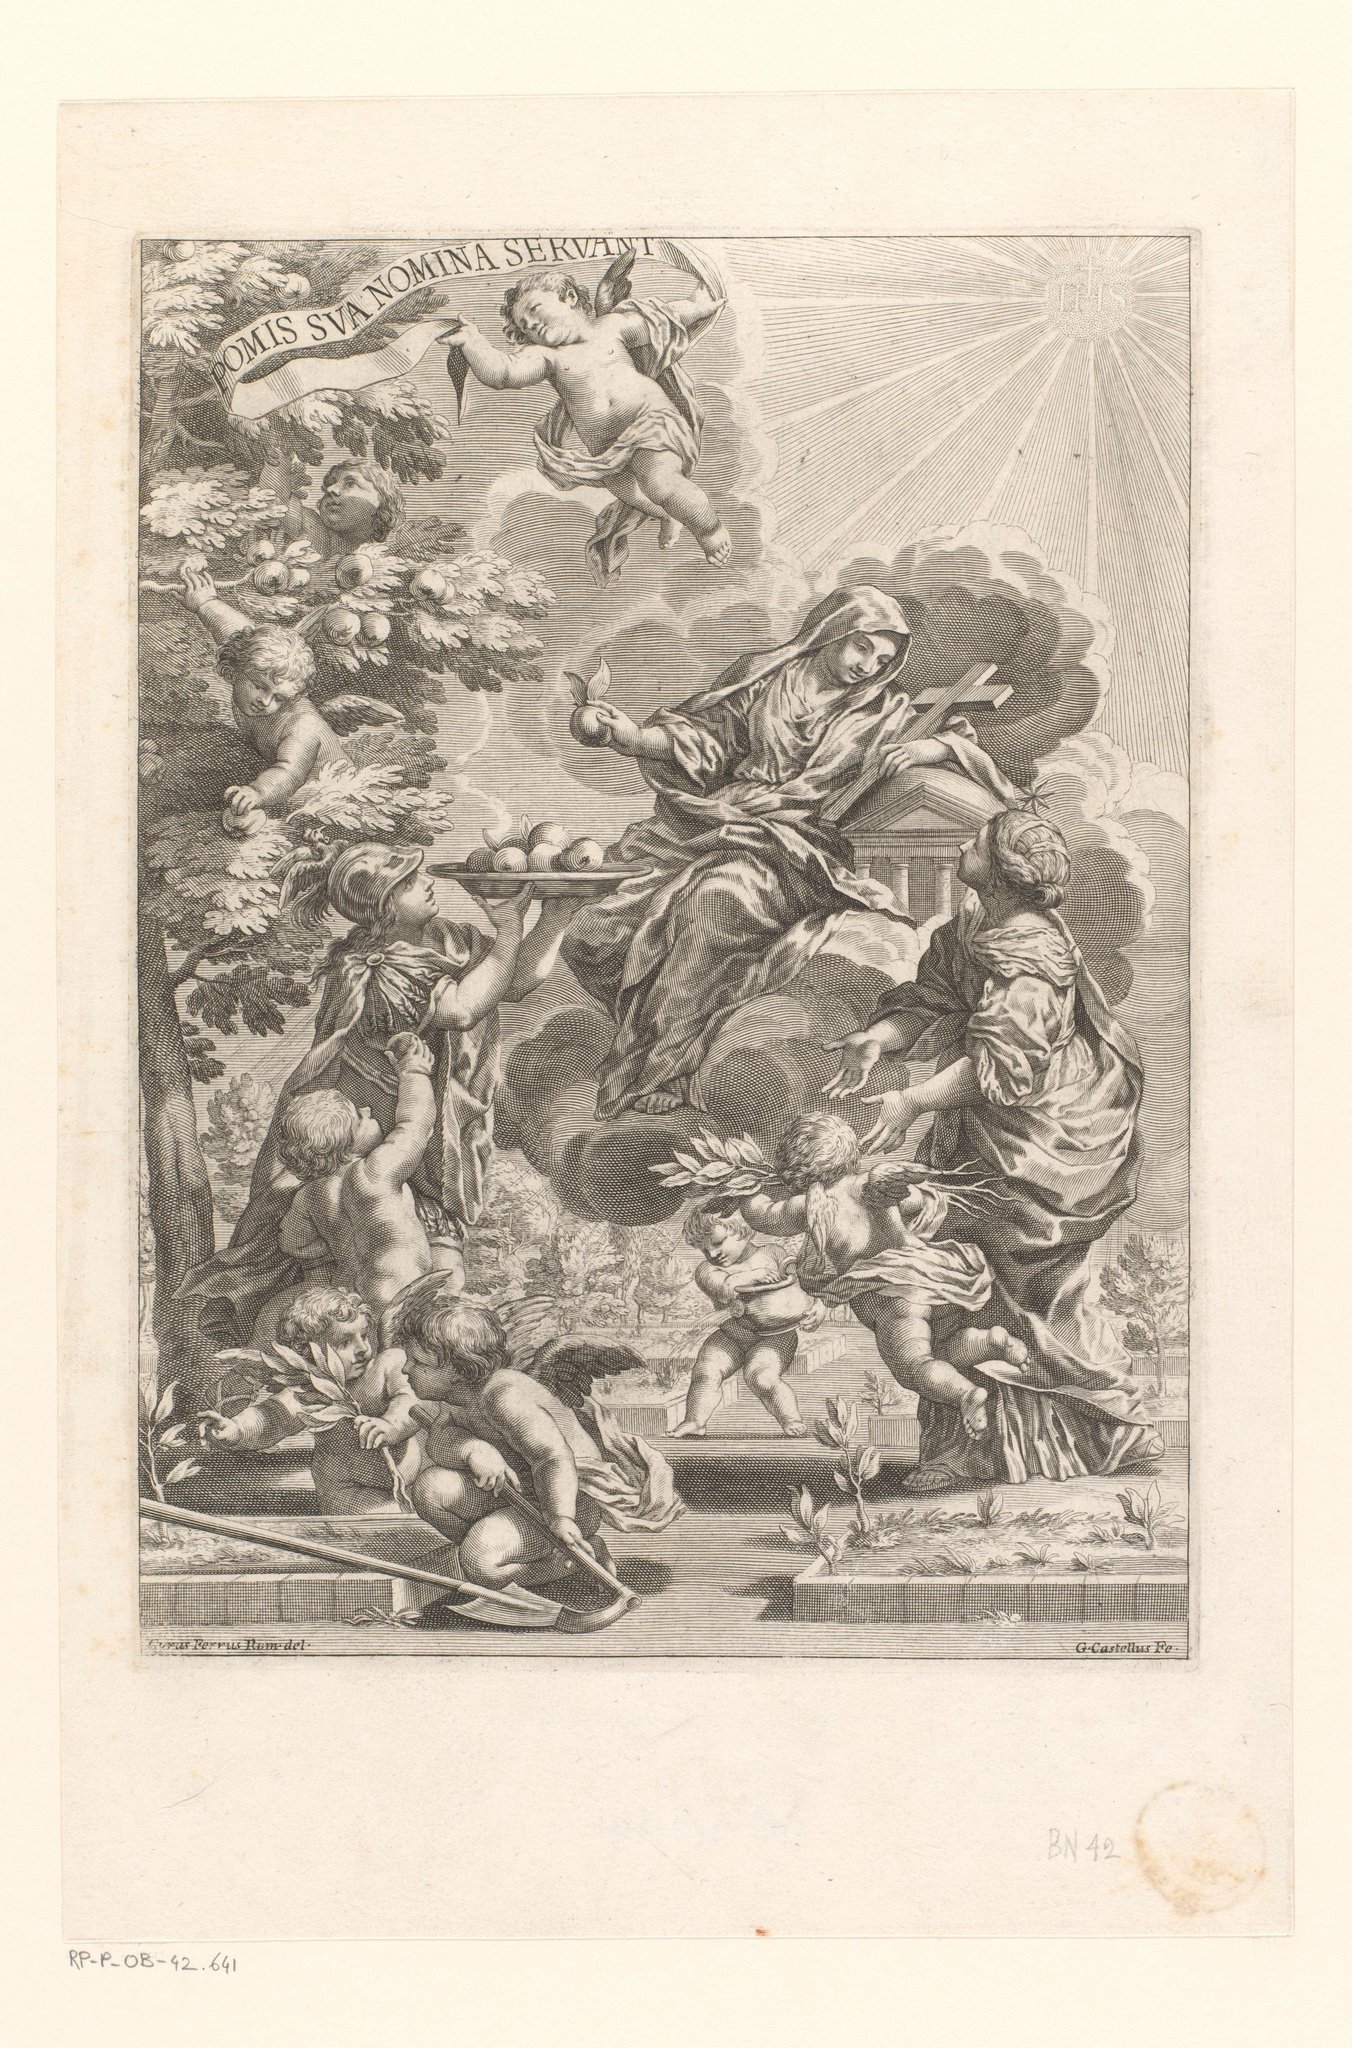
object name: print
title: Titelpagina voor: Annibale Adami, Seminarii romani Pallas purpurata (...), 1659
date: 1659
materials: paper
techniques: engraving, etching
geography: rome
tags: nobility; 'nobiltà' (ripa), fruits: apple, the church personified, 'ecclesia', usually with chalice and banner, 'sapientia', wisdom; 'sapienza divina' (ripa) ~ one of the seven gifts of the holy ghost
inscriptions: collector's mark: Lugt 240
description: Putti planten zaden van de appelboom, geven de planten water, plukken appels en brengen deze aan de allegorische figuren Adel (rechts) en Goddelijke Wijsheid (links), die een plaat appels aanbiedt aan Ecclesia, gezeten op een wolk. De afbeelding is een representatie van de cyclus van het onderwijs en de ontwikkeling van de mens.